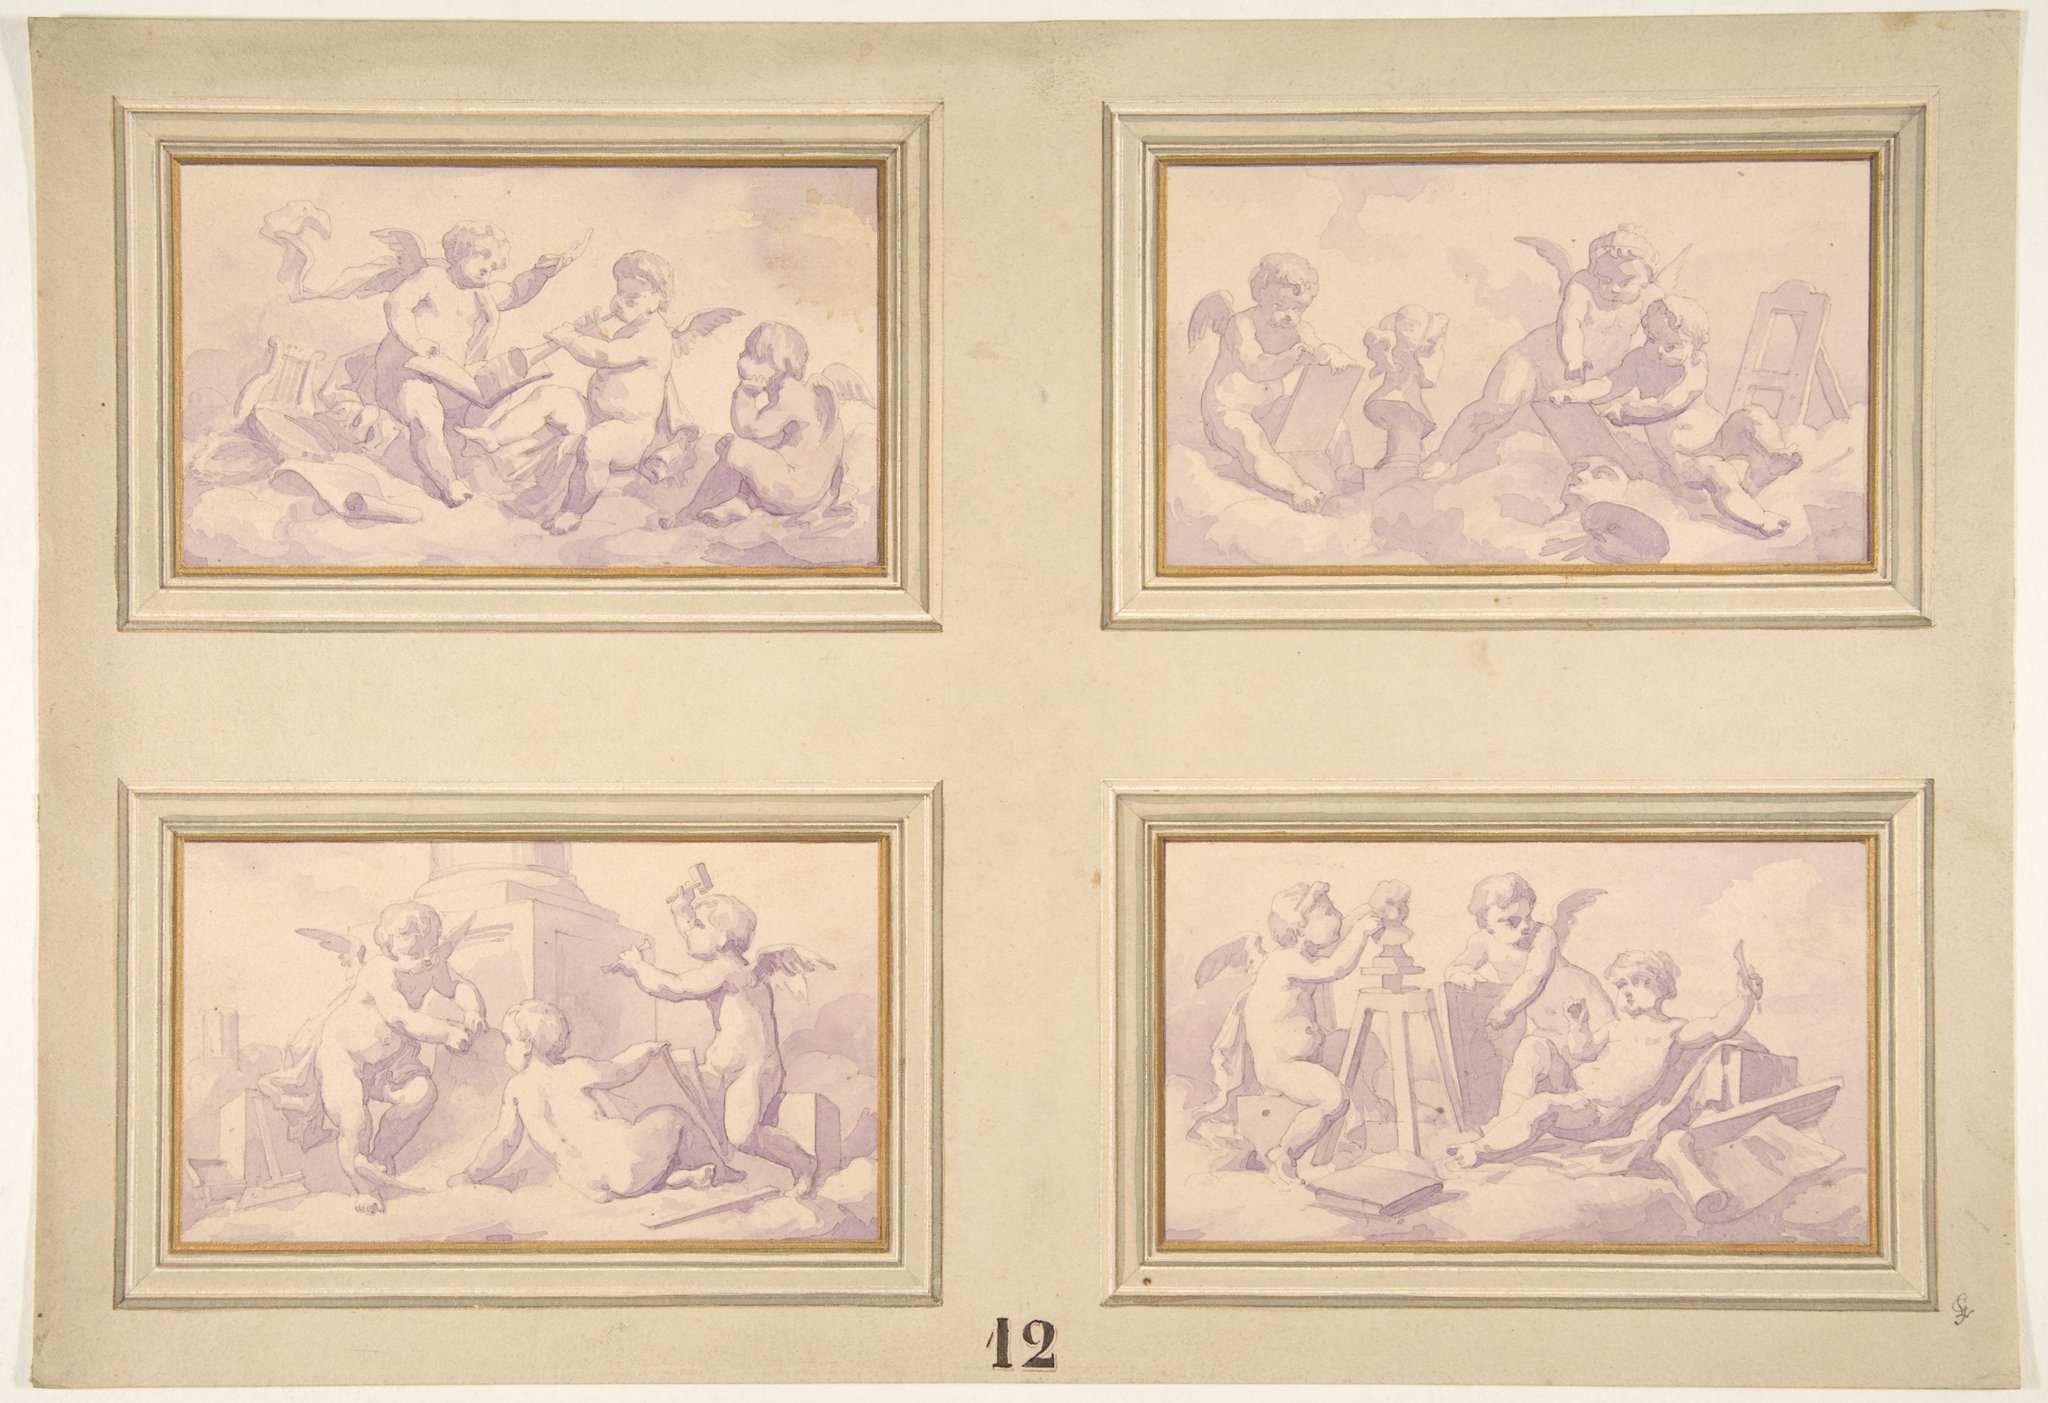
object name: drawing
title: Designs featuring the allegories of the arts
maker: jules-edmond-charles lachaise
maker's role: artist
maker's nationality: french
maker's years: 1897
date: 1851-1900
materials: graphite, watercolor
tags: putti